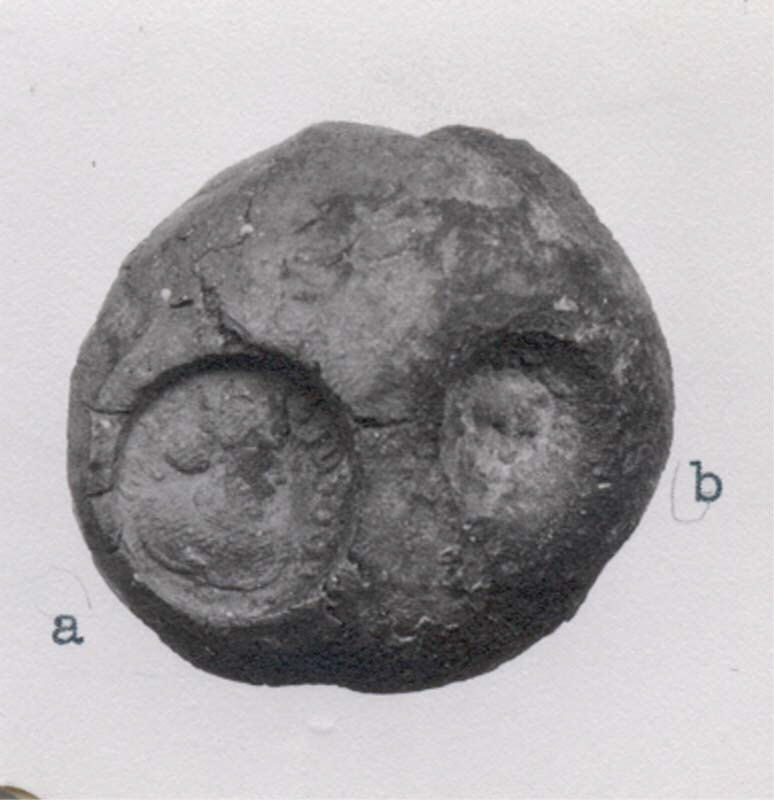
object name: sealing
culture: sasanian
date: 601-700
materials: clay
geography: iran